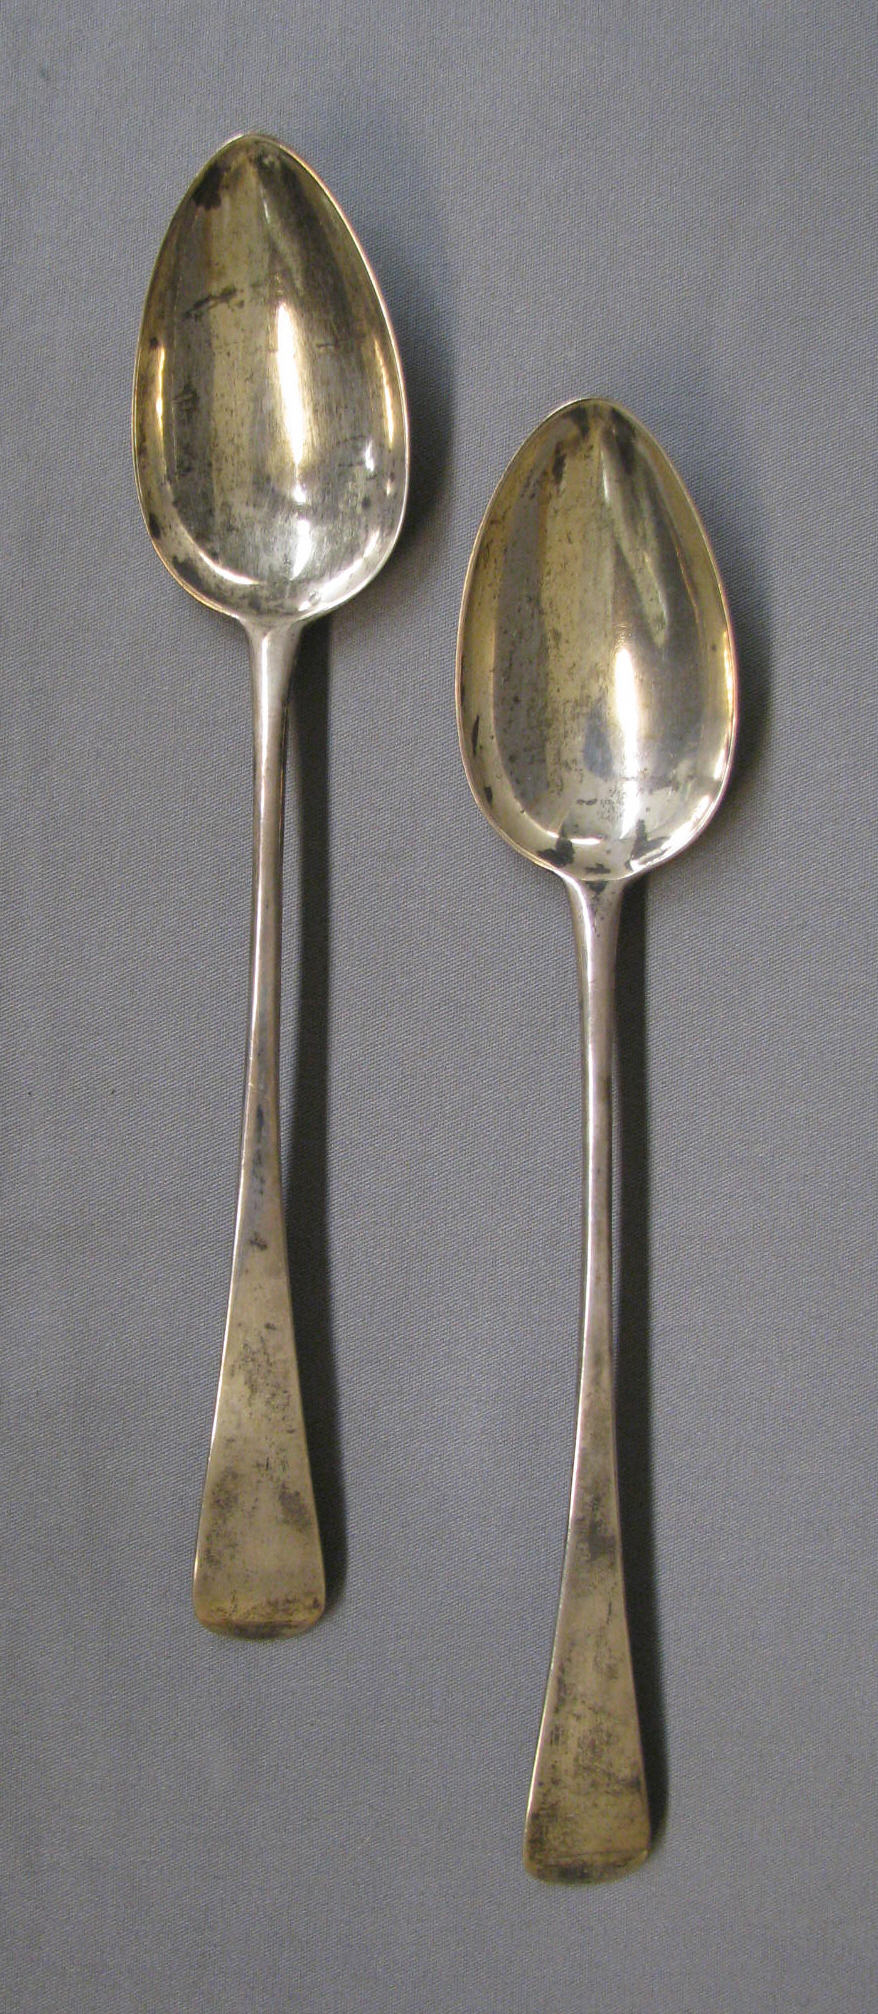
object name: gravy spoon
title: Two gravy spoons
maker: george wintle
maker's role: maker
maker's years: 1787-1823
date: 1807-1808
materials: silver